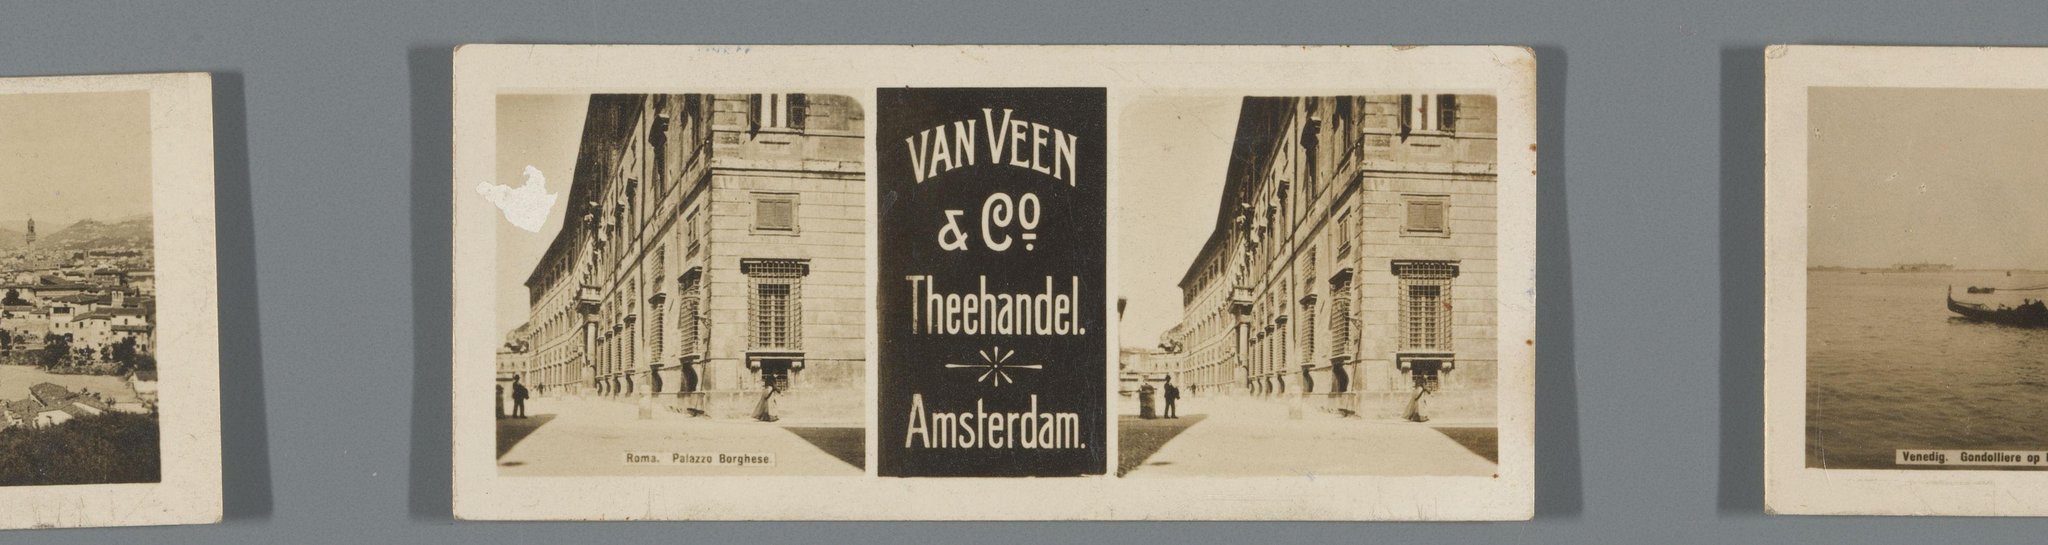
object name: stereograph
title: Gezicht op het Palazzo Borghese in Rome, reclame voor Theehandel van Veen & Co.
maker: Anonymous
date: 1910-1920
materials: paper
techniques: gelatin silver print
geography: rome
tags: palace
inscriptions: inscription: ‘Stereoscopen voor deze plaatjes/ zijn verkrijgbaar à 25 cents per stuk/ bij VAN VEEN & Co., Amsterdam,/ Rotterdam, Den Haag, Nijmegen/ Haarlem en Hilversum.’